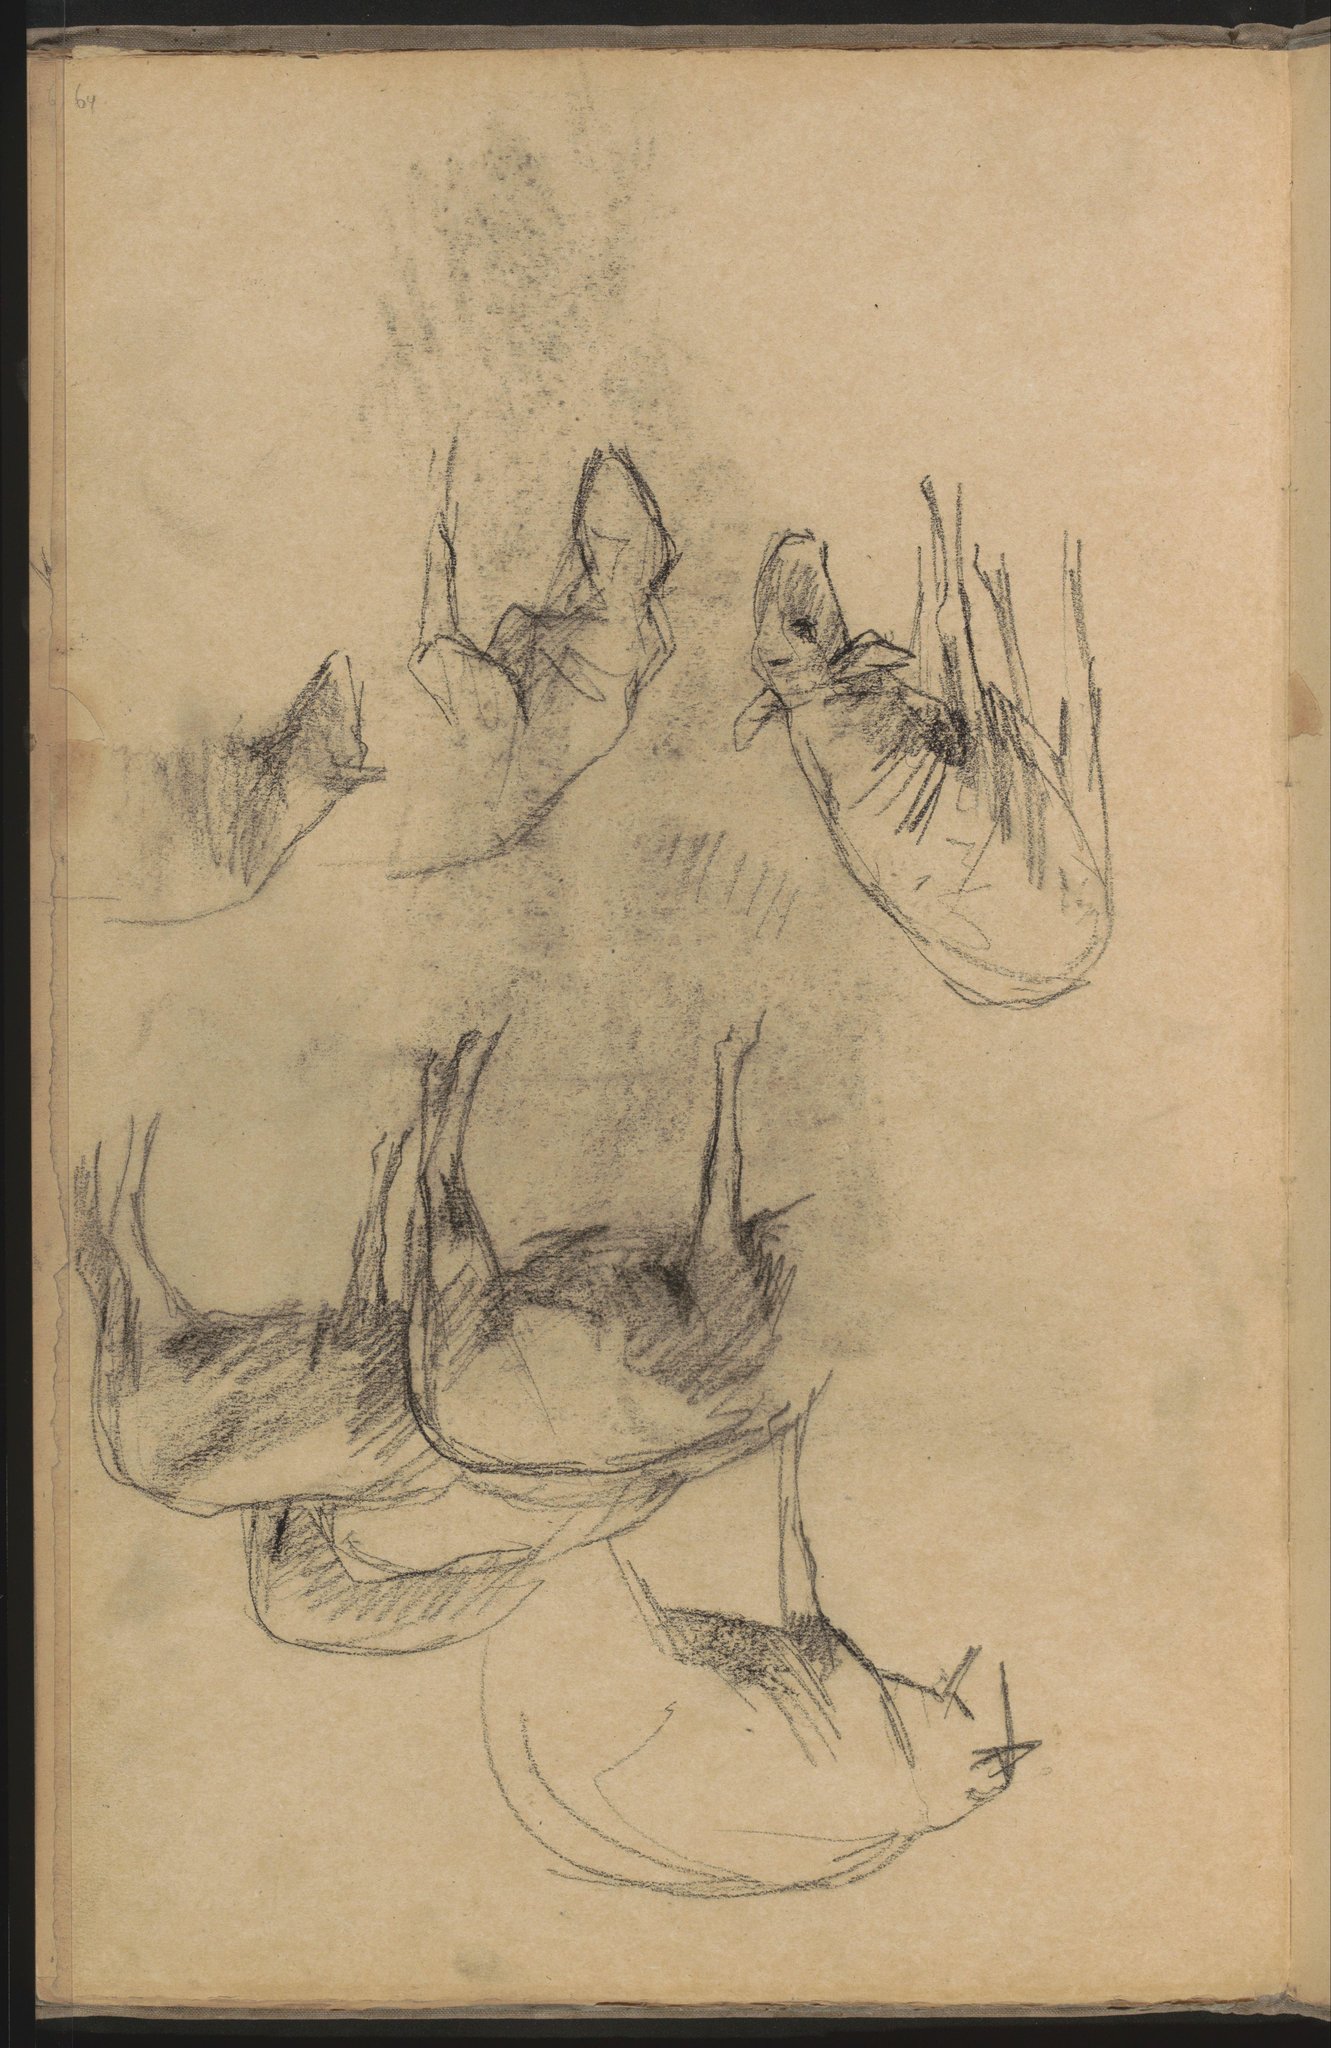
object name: sketchbook leaf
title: Studieblad met schapen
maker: willem witsen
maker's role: draughtsman, painter, print maker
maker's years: 1860-1923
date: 1884-1887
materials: chalk, paper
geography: ewijkshoeve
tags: sheep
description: Pagina 64 uit een schetsboek met 42 bladen vervaardigd rond de Ewijkshoeve.